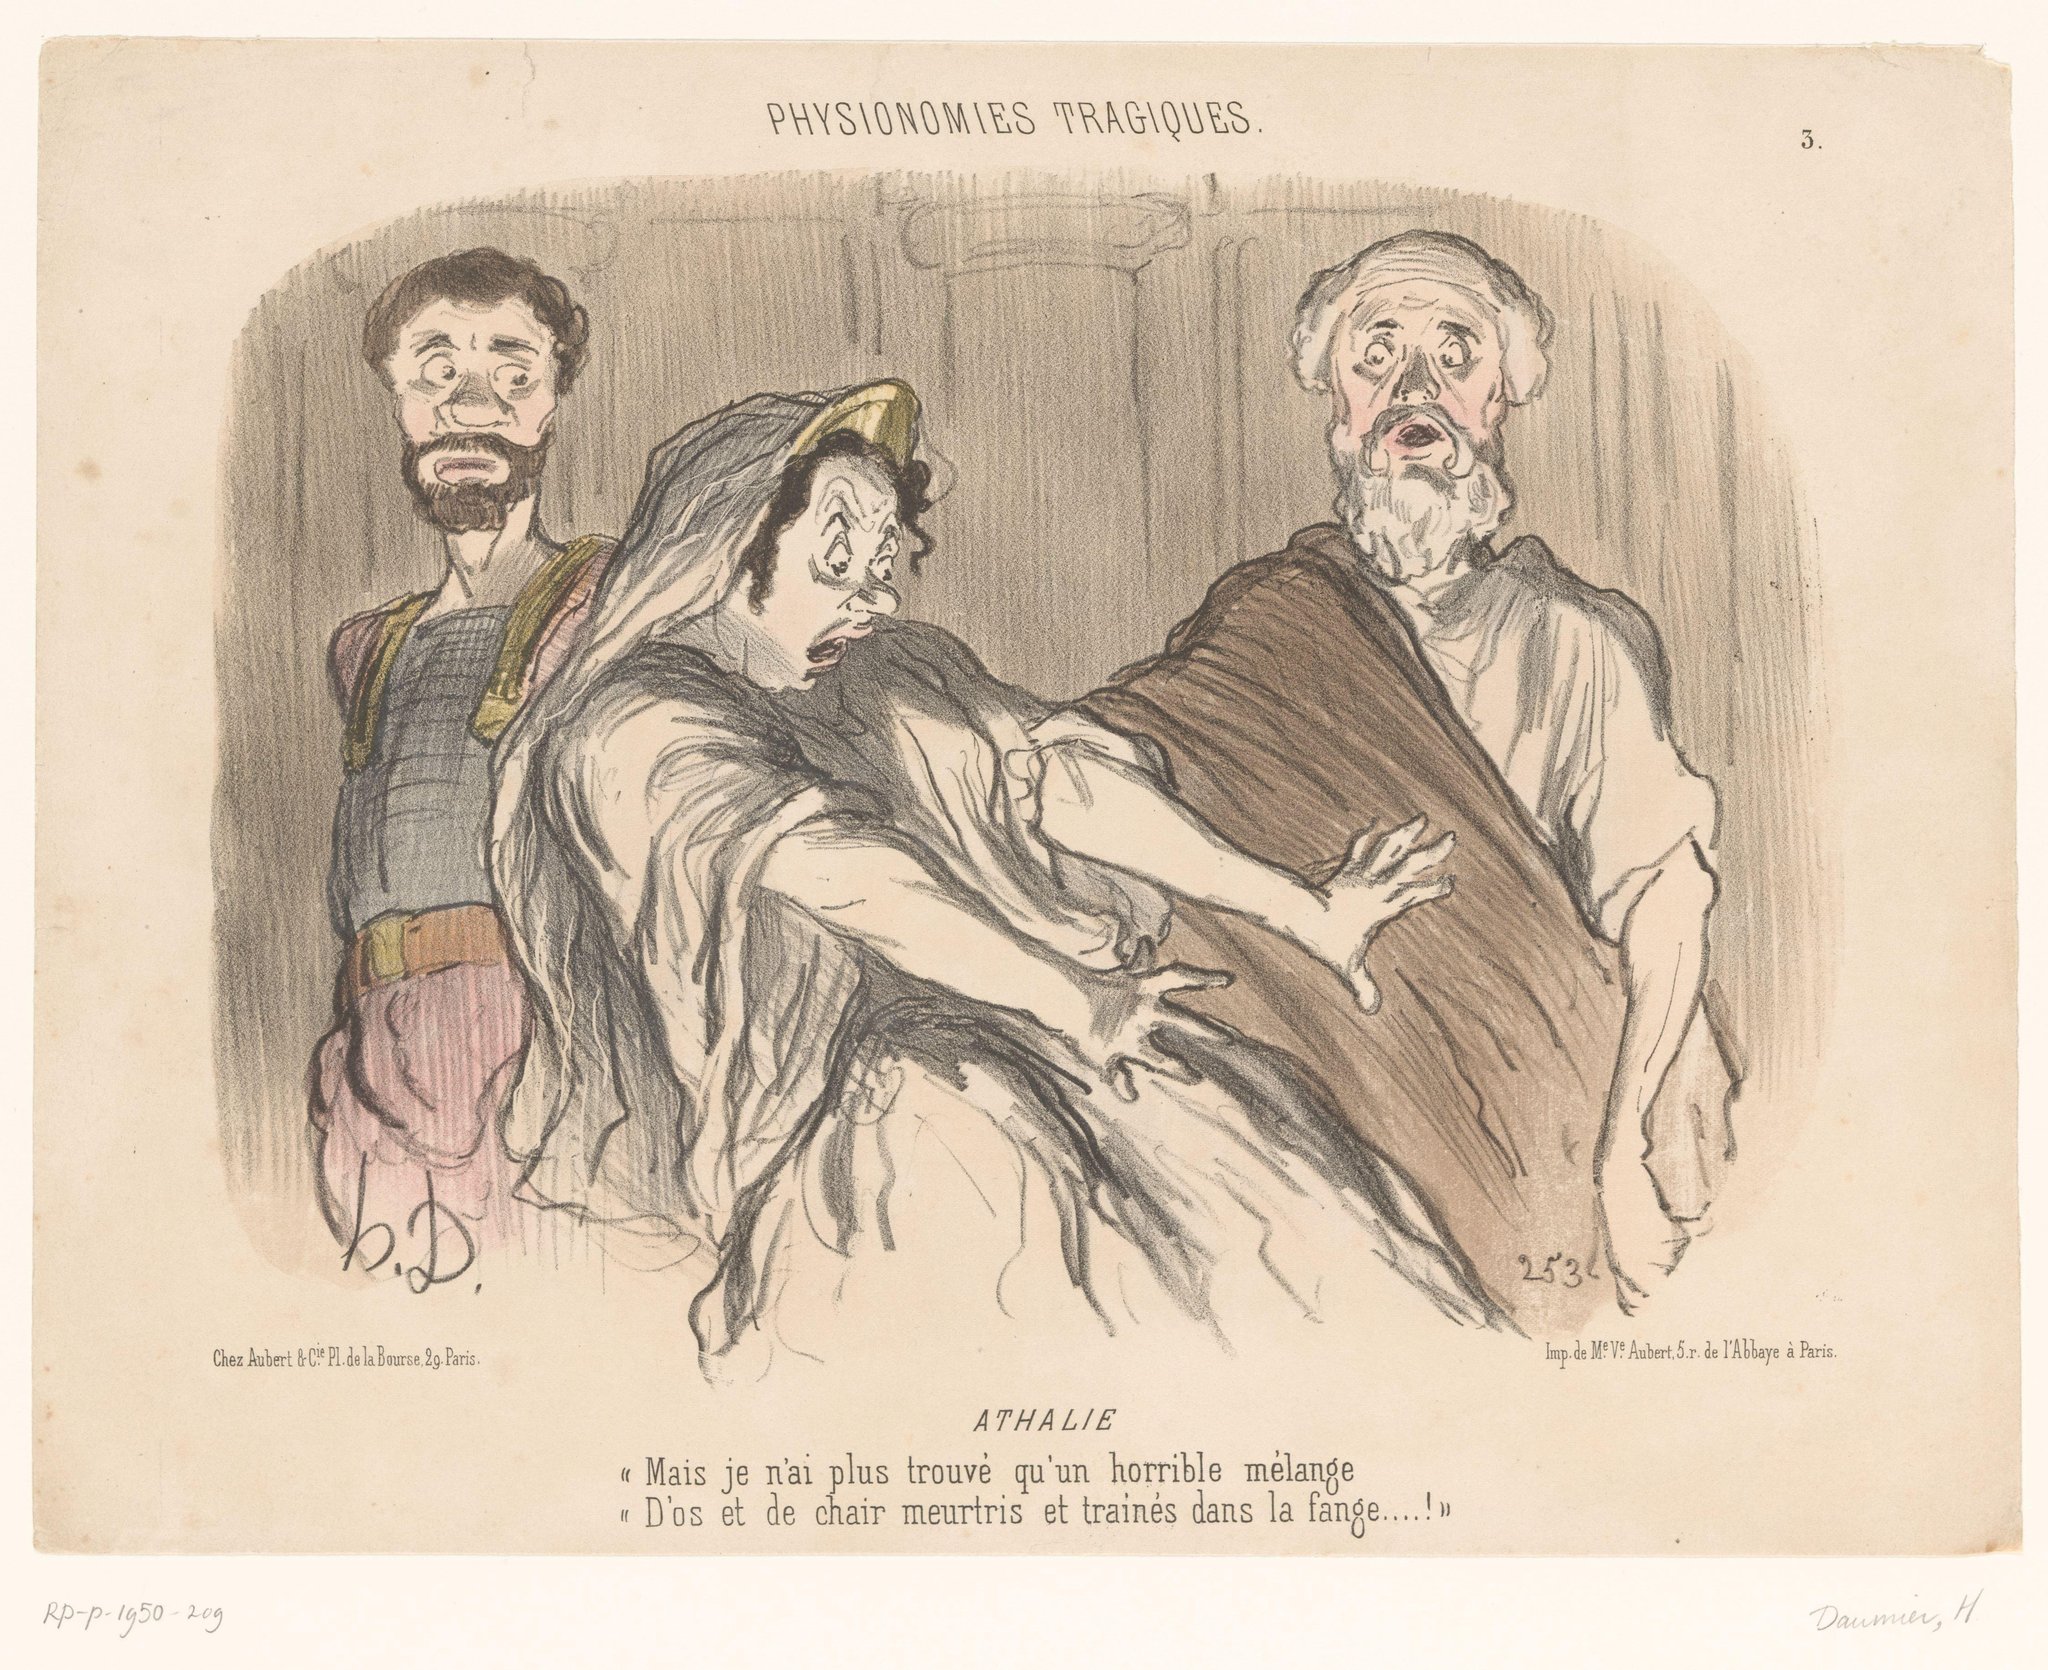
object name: print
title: Tragische gezichten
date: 1851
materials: paper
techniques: hand coloring, lithograph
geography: paris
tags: story of athalia, queen of judah (2 kings 11:1-3, 11:13-16; 2 chronicles 22:10-12, 23:12-15)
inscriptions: collector's mark: Lugt 2228a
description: Prent gebruikt voor: Le Charivari, 8 maart 1851. De scène is afkomstig uit de tragedie Athalie van Jean Racine.